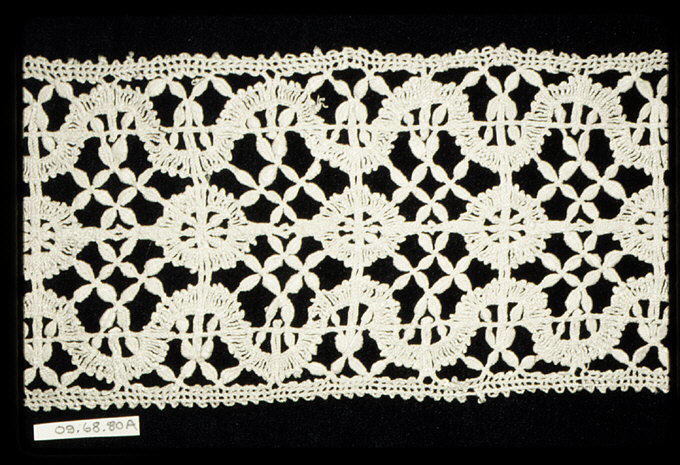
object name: insertion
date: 1601-1700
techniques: lace